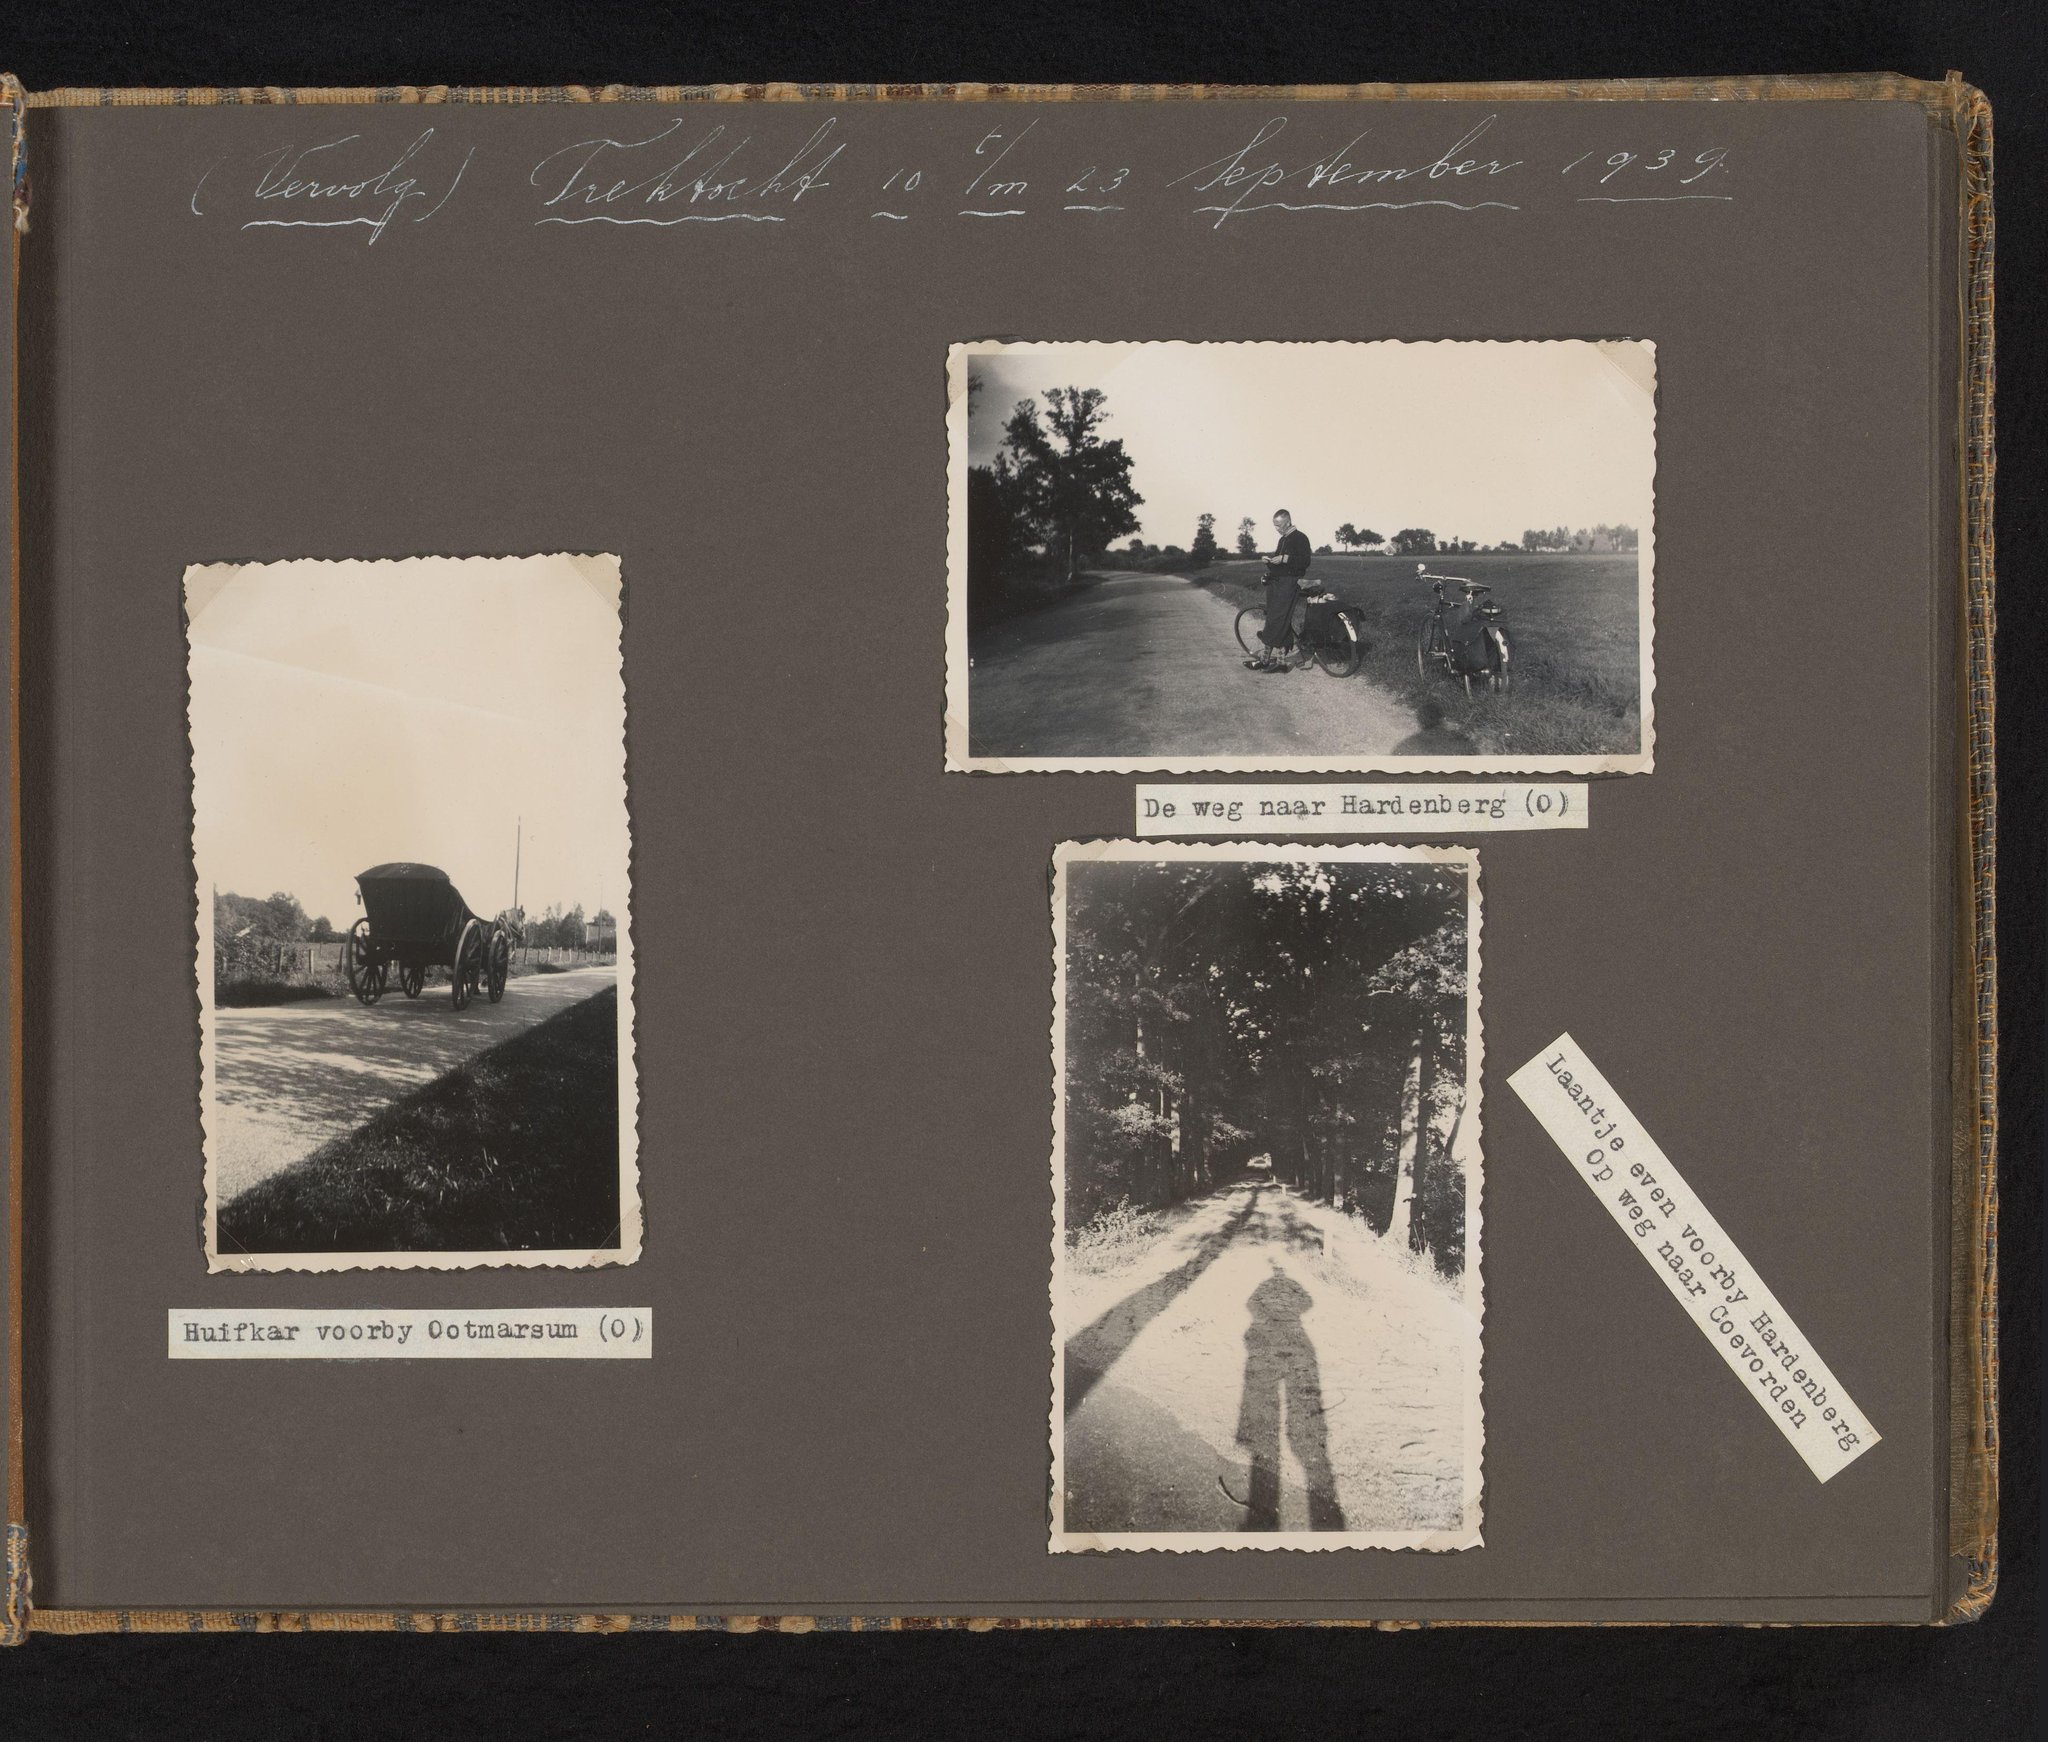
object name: photograph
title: Ootmarsum en Hardenberg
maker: Anonymous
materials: paper, photographic support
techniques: gelatin silver print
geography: netherlands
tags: riding, cycling (recreation), father with son(s) (father-love), outing, pleasure trip, bicycle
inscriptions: inscription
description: Albumblad met drie foto's in de omgeving van Ootmarsum en Hardenberg. Onder de foto's uitgeknipte papiertjes met getypte opschriften. Onderdeel van het eerste fotoalbum met foto's van de twee fietstochten van vader en zoon door Nederland in september 1939 en juli 1940 en een autotrip met het gezin door Nederland, België en Luxemburg in juni 1949.